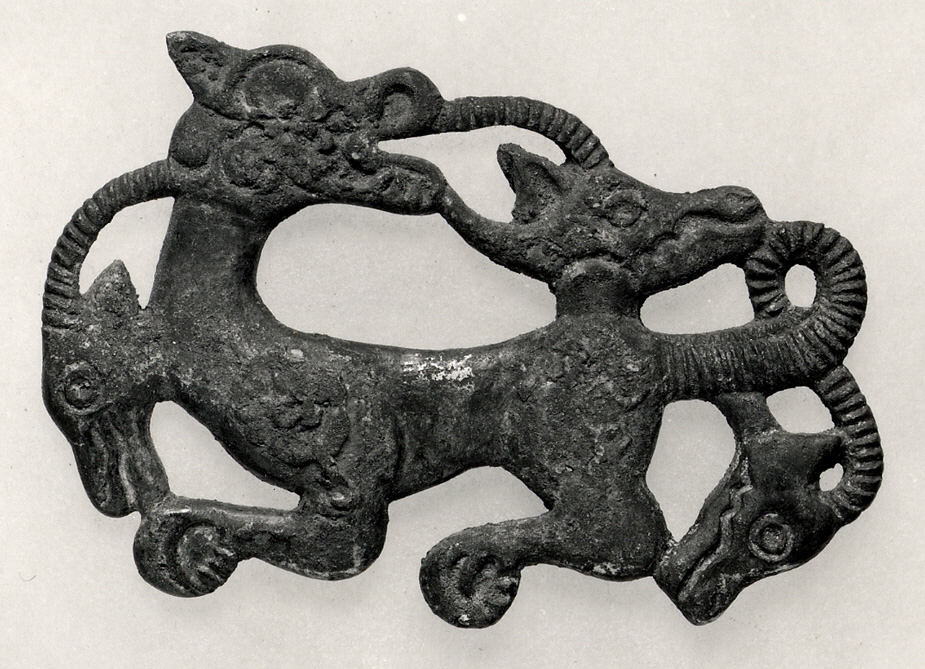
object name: plaque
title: Plaque with Tiger and Antelope Heads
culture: north chinese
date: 300-1 BCE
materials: gilt bronze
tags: tigers